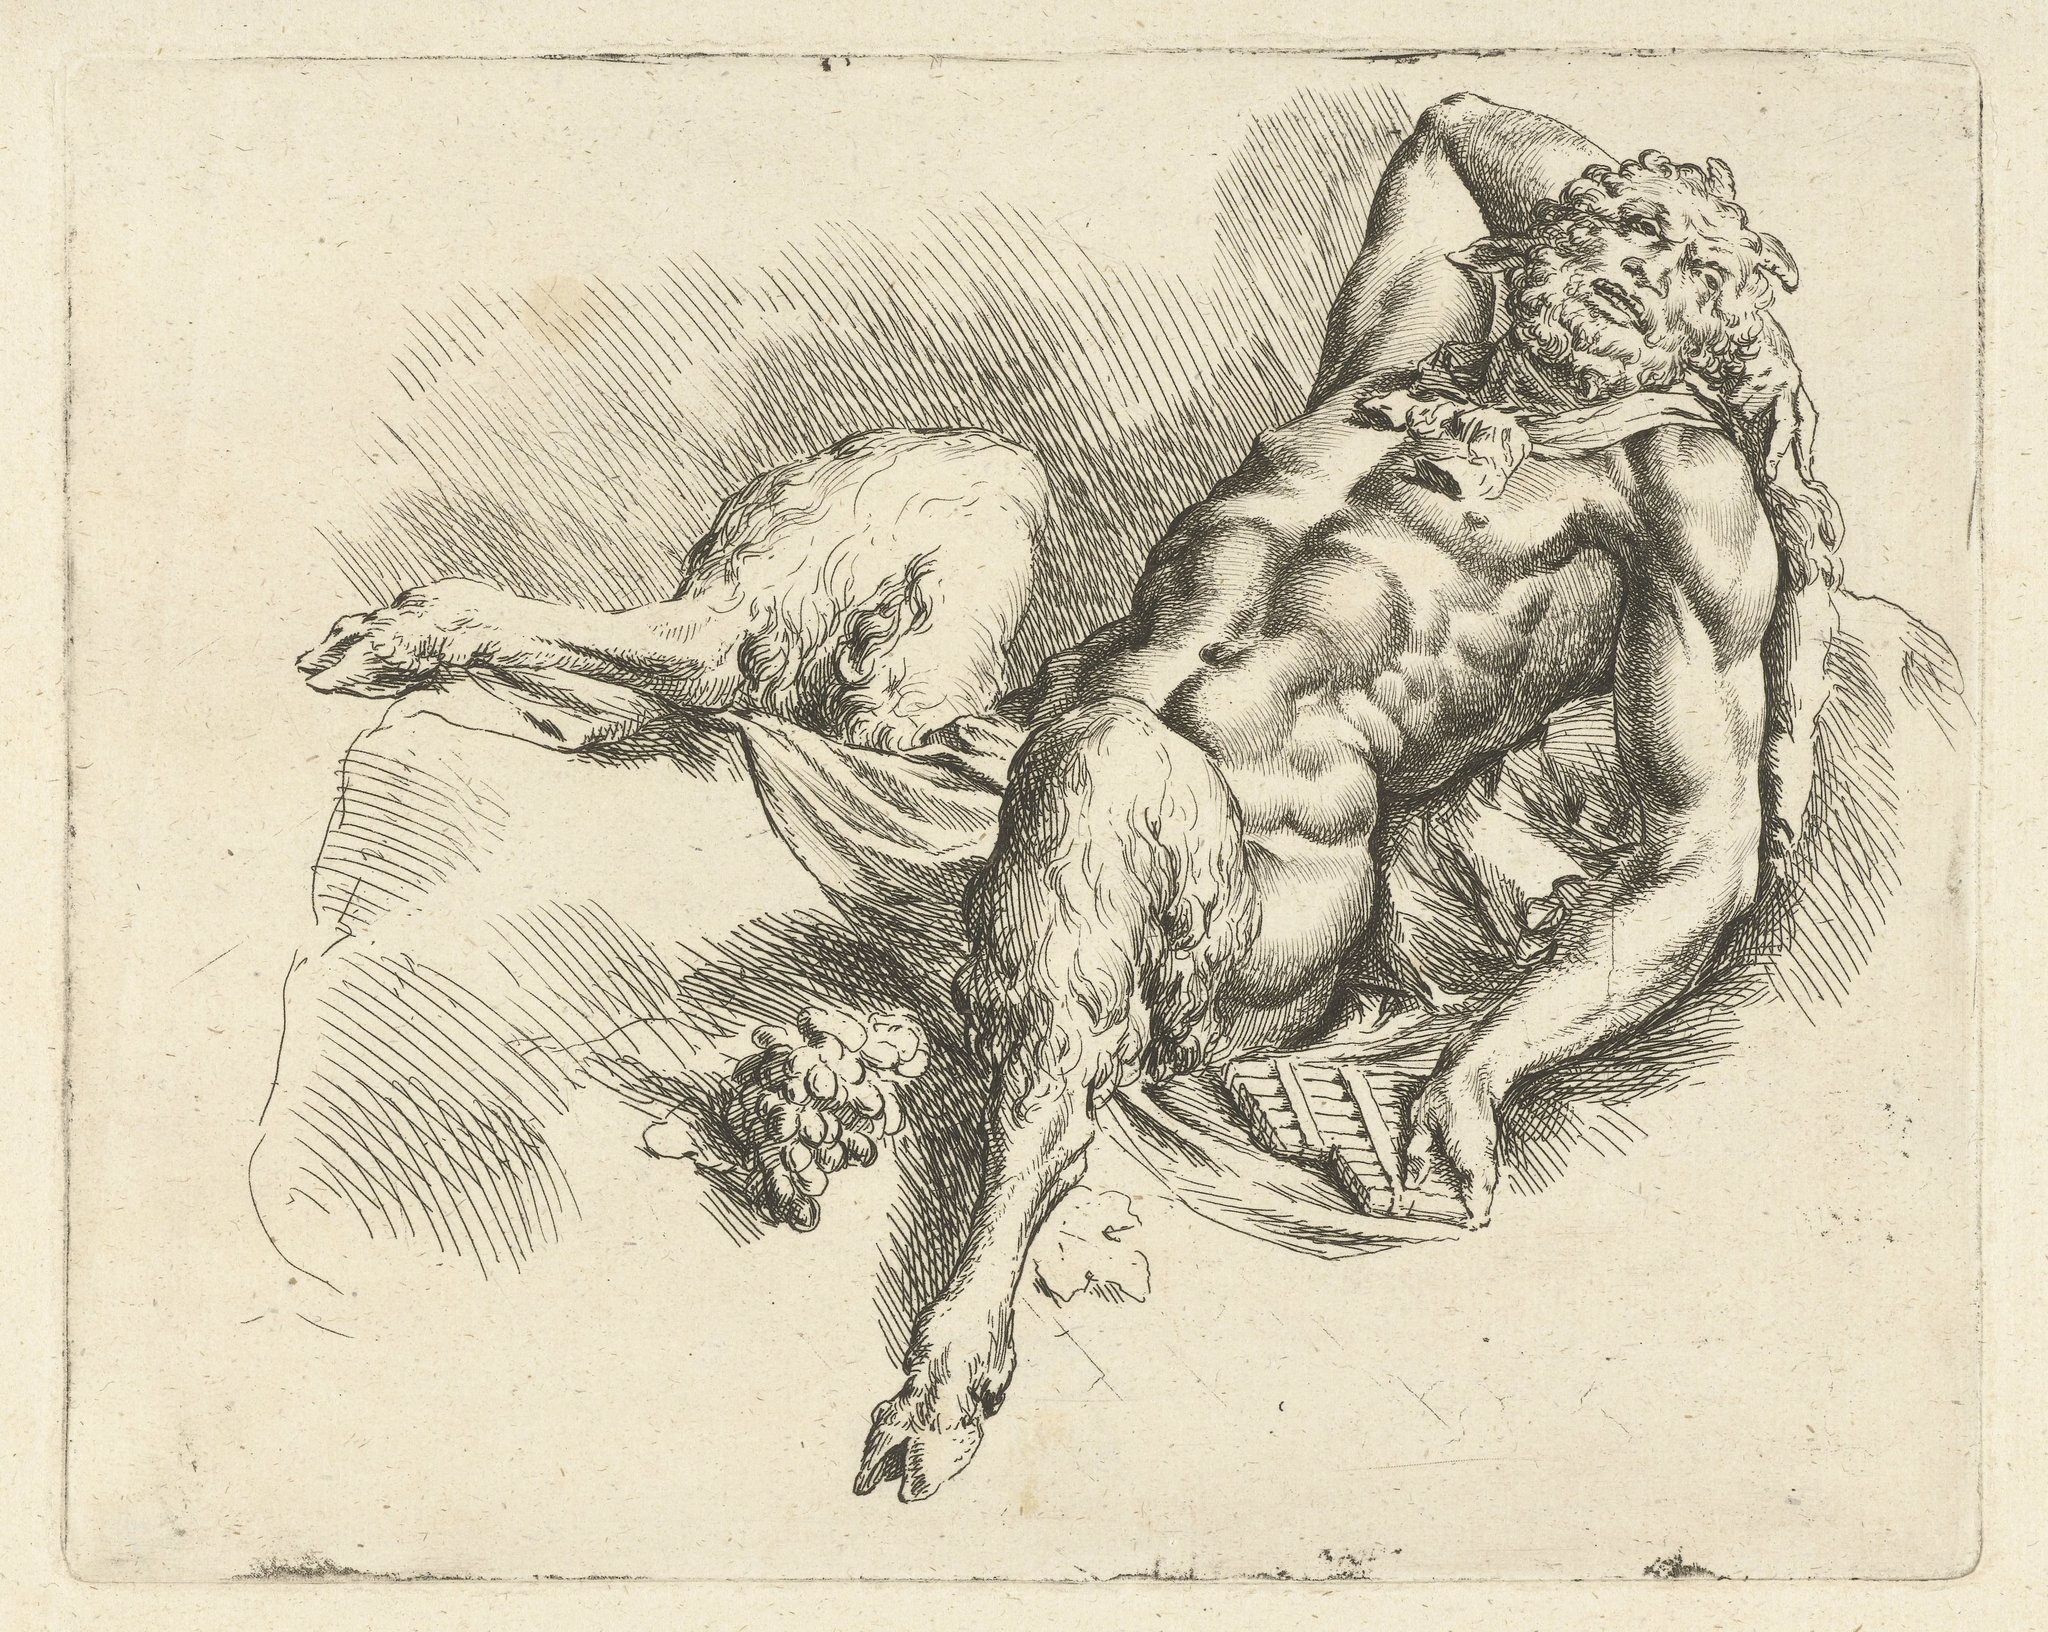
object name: print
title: Signorum Veterum Icones II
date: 1664-1669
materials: paper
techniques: etching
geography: northern netherlands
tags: (story of) pan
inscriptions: collector's mark: Lugt 2228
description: afkomstig uit: Jan de Bisschop, Signorum Veterum Icones, deel 2, [c. 1669]